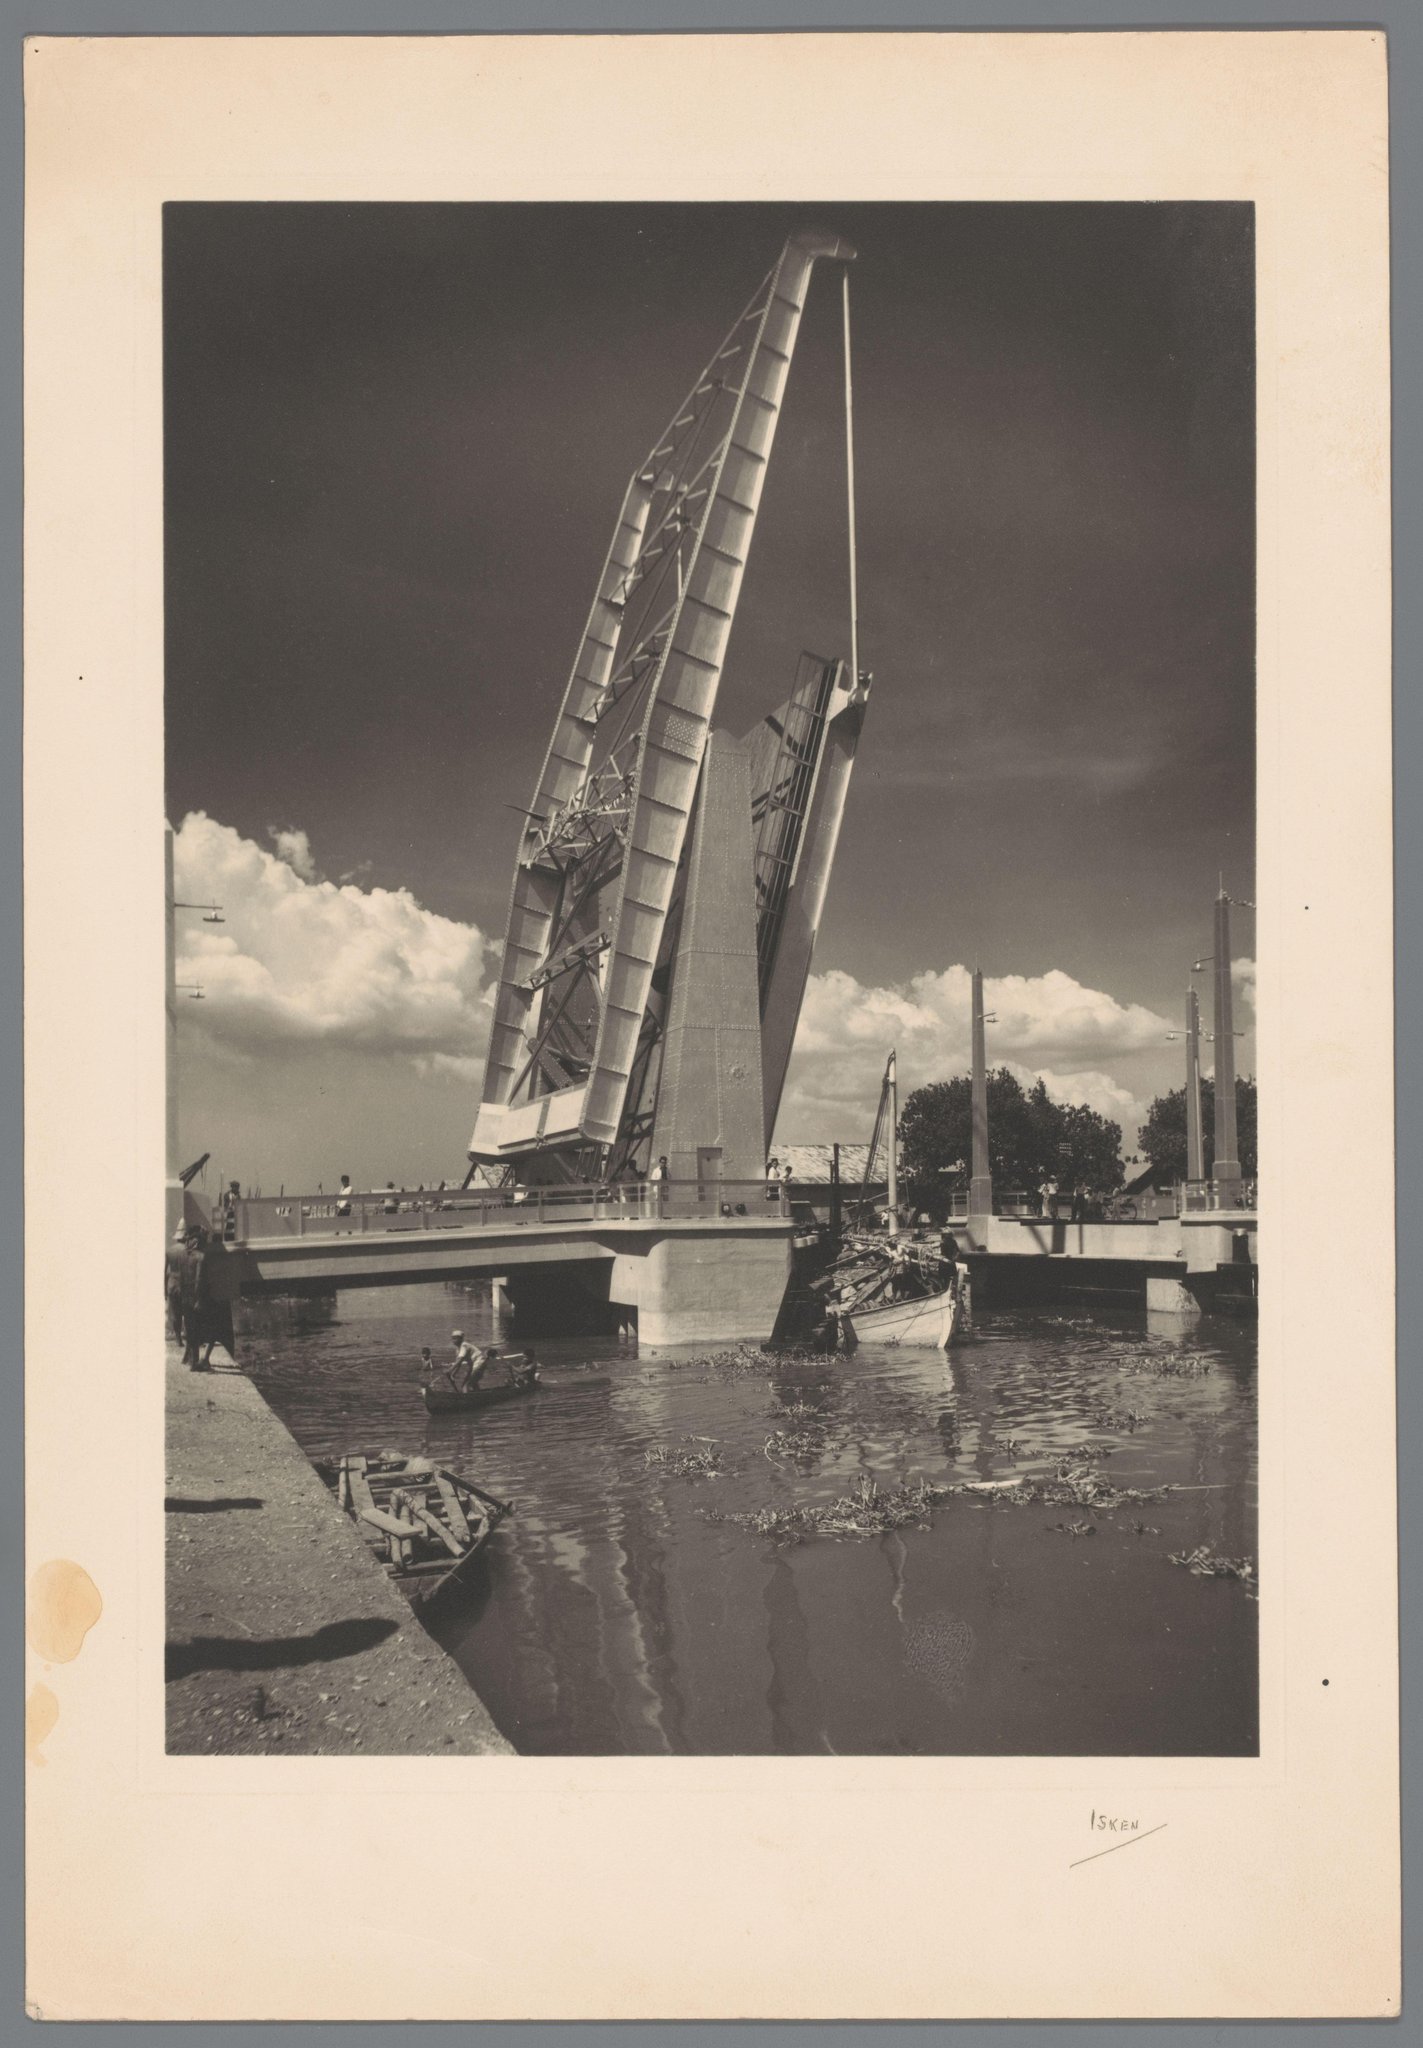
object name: photograph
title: Admiraal Ferwerdabrug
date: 1940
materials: photographic support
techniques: gelatin silver print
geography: surabaya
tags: colonial system, bascule bridge, java, surabaya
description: Ophaalbrug, de Admiraal Ferwerdabrug, over de Kali Mas in Soerabaja. Onderdeel van de multomap met foto's van bruggen gebouwd door de N.V. Machinefabriek Braat te Soerabaja en bestemd voor verschillende plaatsen in Nederlands-Indië, uit de periode 1931-1940.